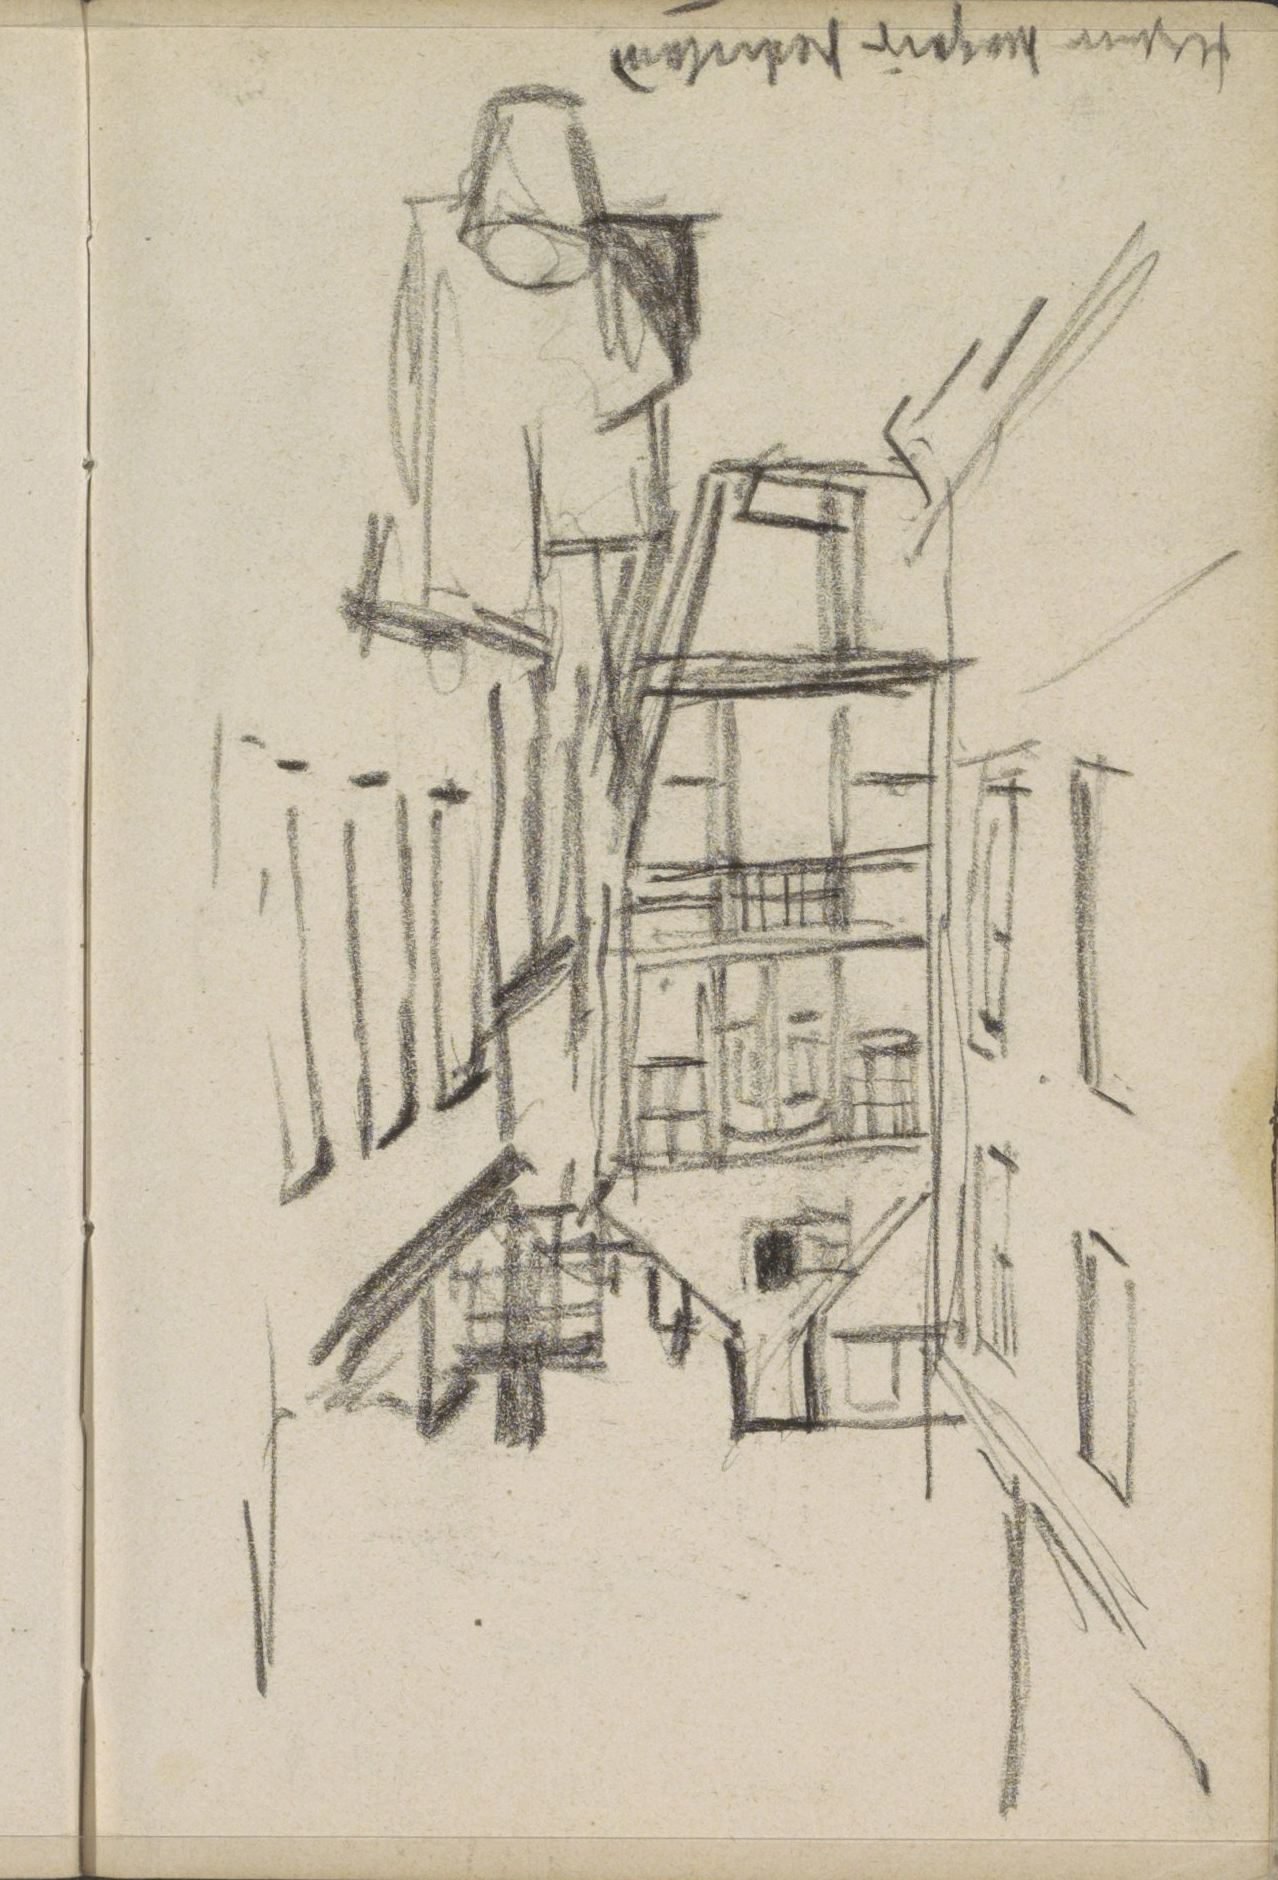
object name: sketchbook leaf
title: Gezicht op gebouwen tegenover het Magazijn Nederland, Dam 4 te Amsterdam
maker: george hendrik breitner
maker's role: draughtsman, painter, print maker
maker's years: 1857-1923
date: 1900-1923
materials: chalk, paper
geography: amsterdam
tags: civic architecture; edifices; dwellings, amsterdam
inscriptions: annotation: ‘tegenover Magazijn Nederland’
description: Pagina 66 uit een schetsboek met 39 bladen.